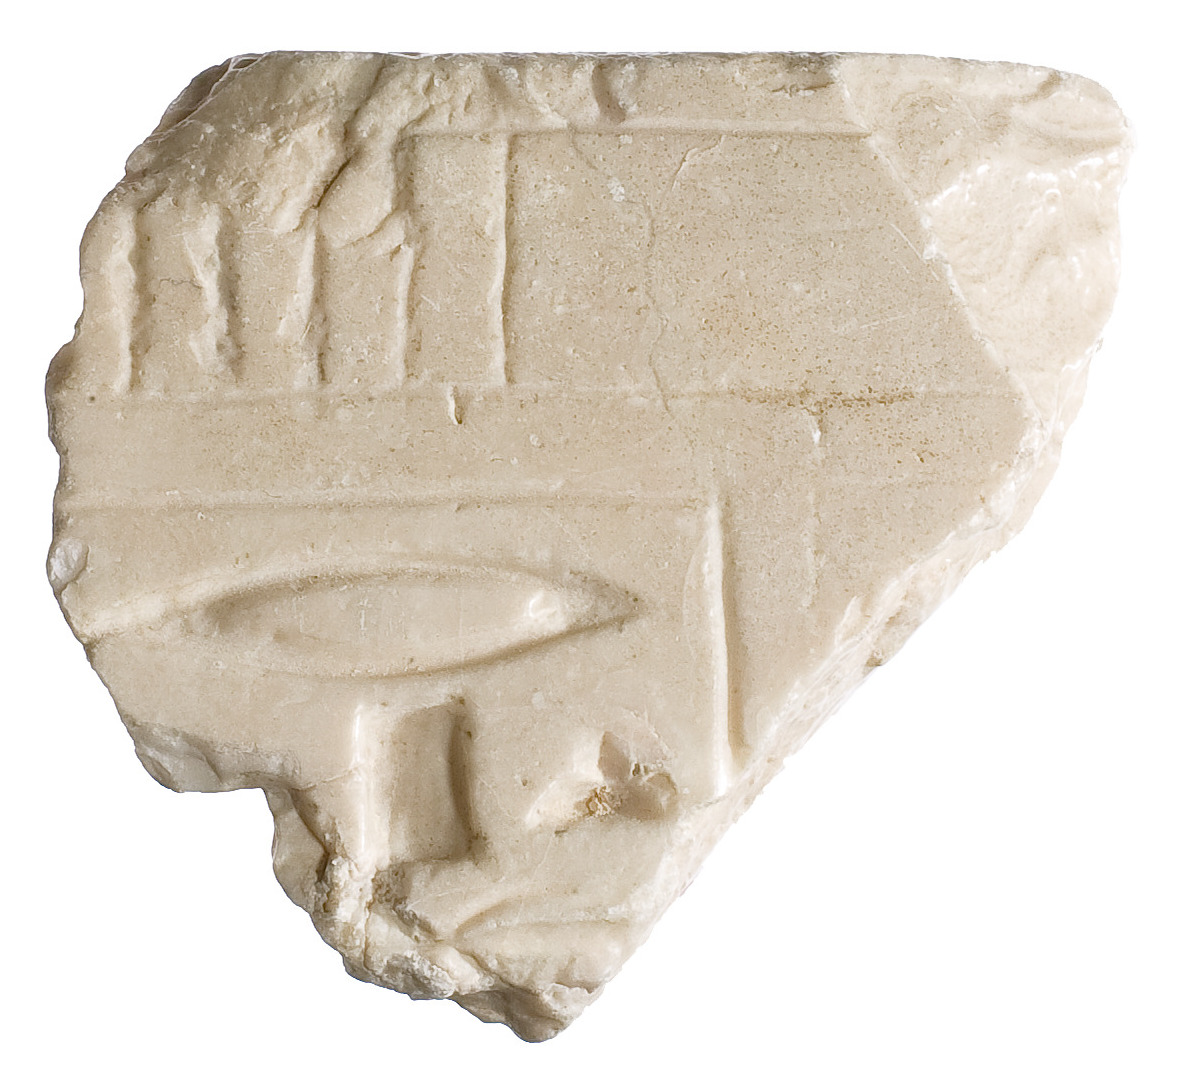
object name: throne block, nefertiti titulary, border pattern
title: Throne block with Nefertiti titulary, border pattern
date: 1353-1336 BCE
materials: limestone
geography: egypt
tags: hieroglyphs,chairs